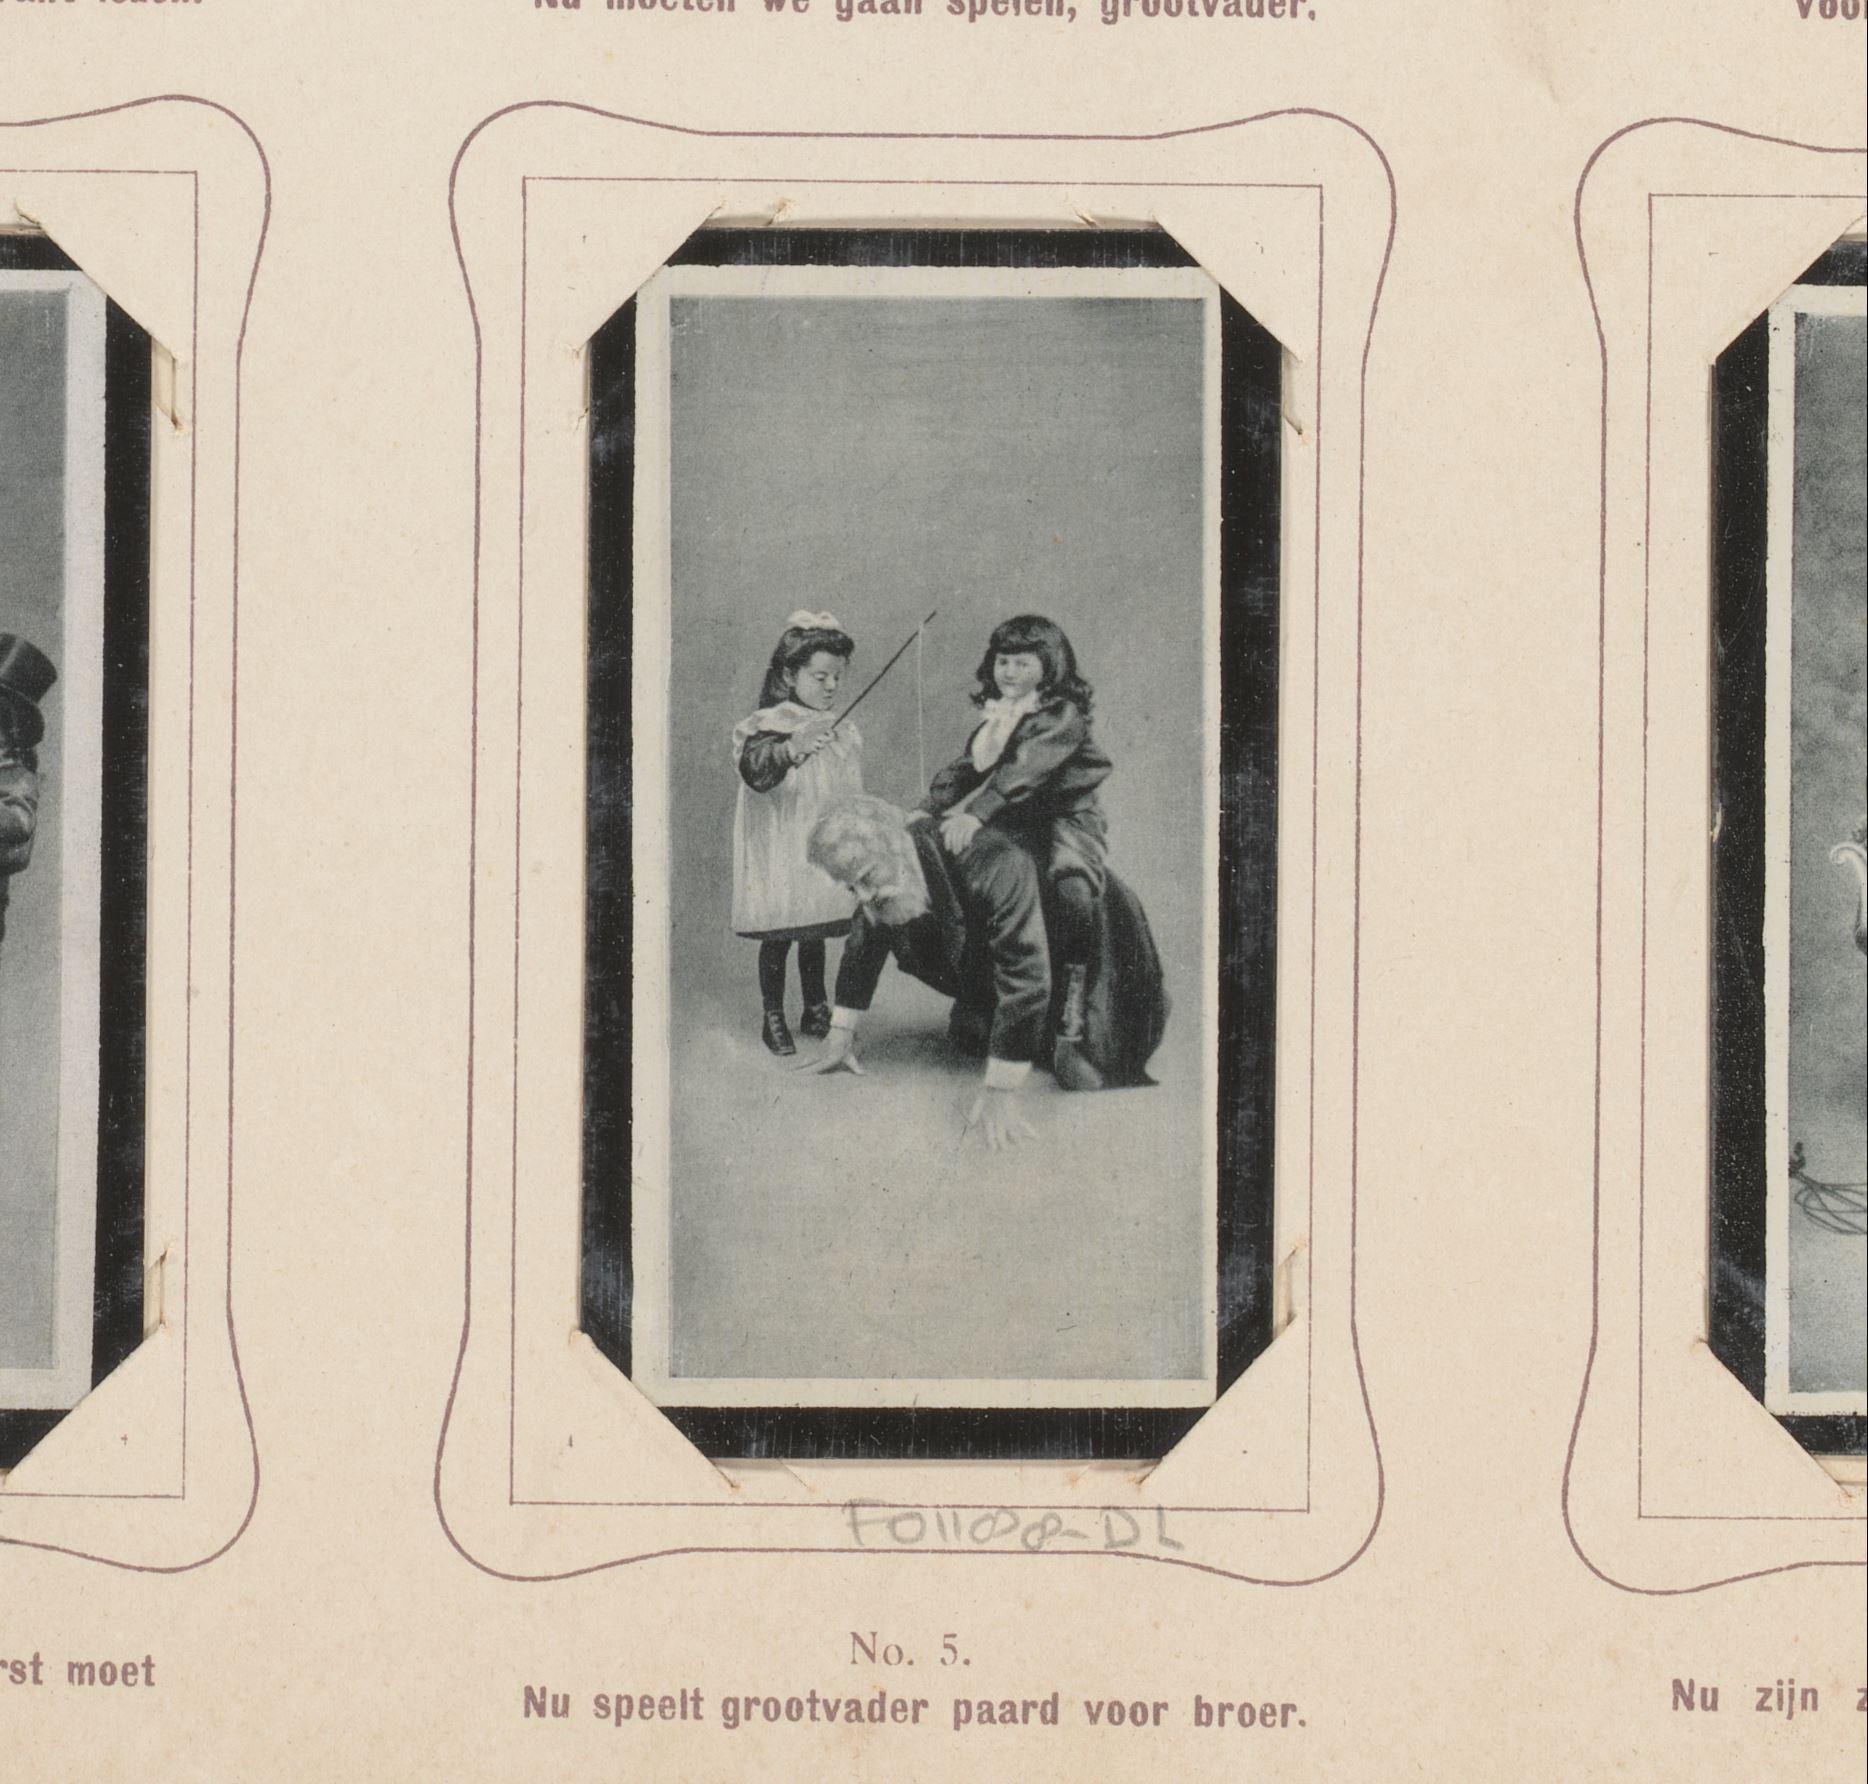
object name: album leaf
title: Reproductie van een tekening van een opa spelend met zijn kleinkinderen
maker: Anonymous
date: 1906-1907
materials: paper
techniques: photograph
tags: children's games and plays, grandparent(s) with grandchild(ren) (family group)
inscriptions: inscription: ‘No. 5./ Nu speelt grootvader paard voor broer.’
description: Deze prent maakt deel uit van een album.